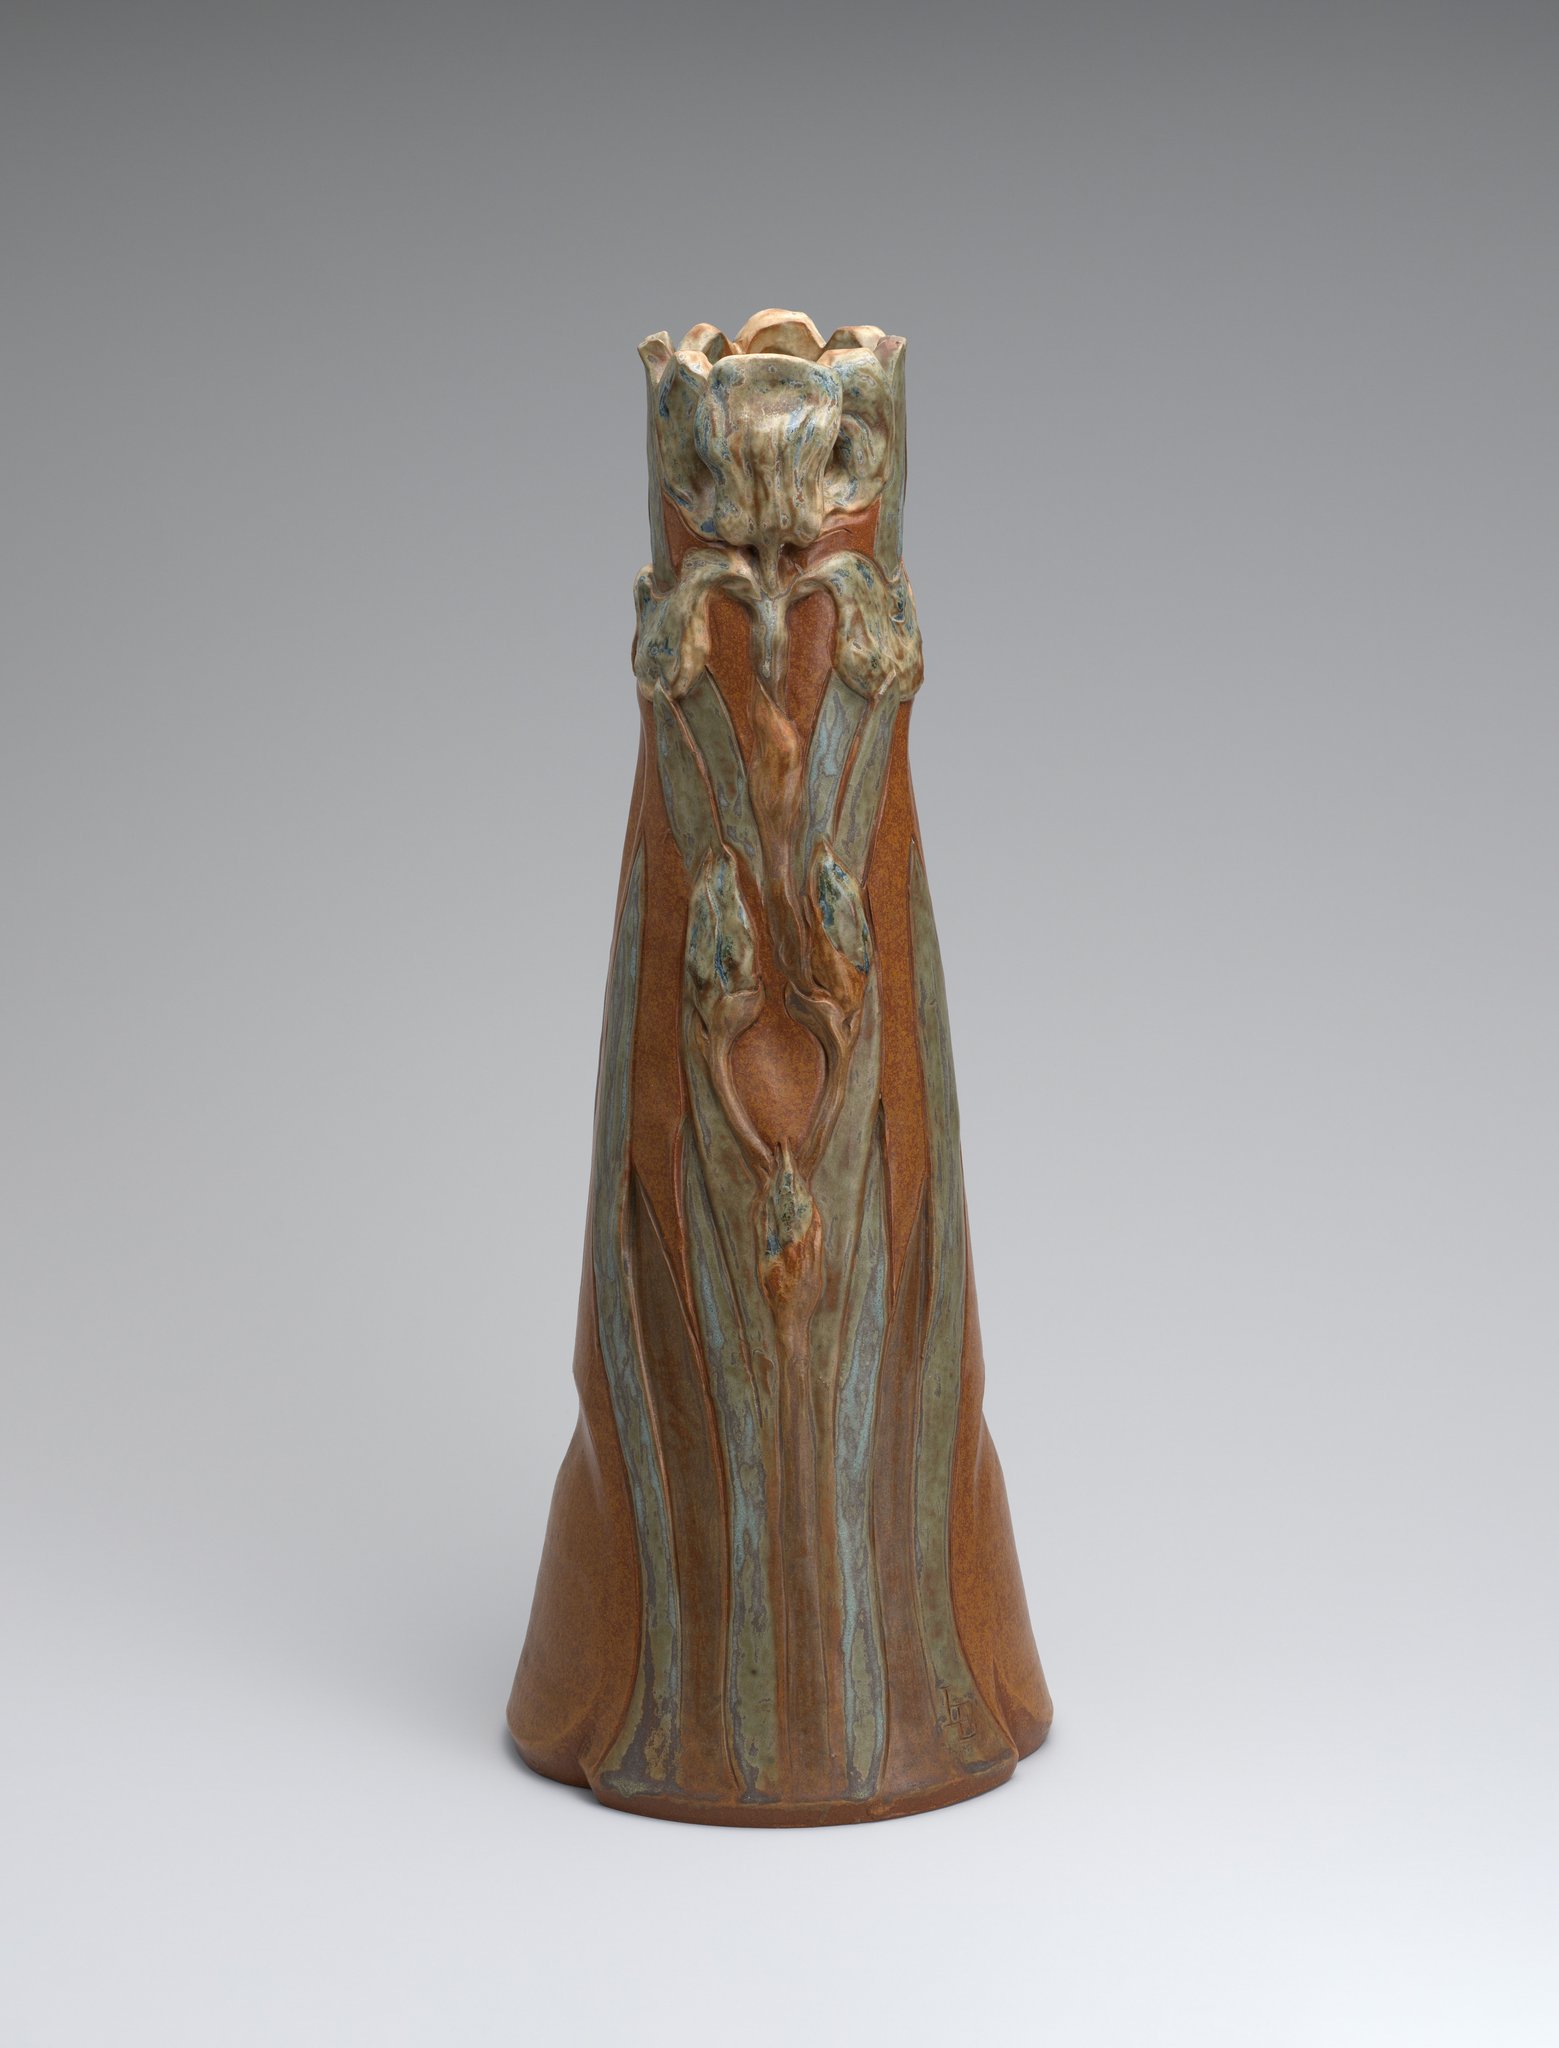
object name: vase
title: Vase with iris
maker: lucien jules clément d'eaubonne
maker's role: designer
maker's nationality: french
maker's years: 1870-1970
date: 1903-1904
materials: stoneware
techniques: glazing